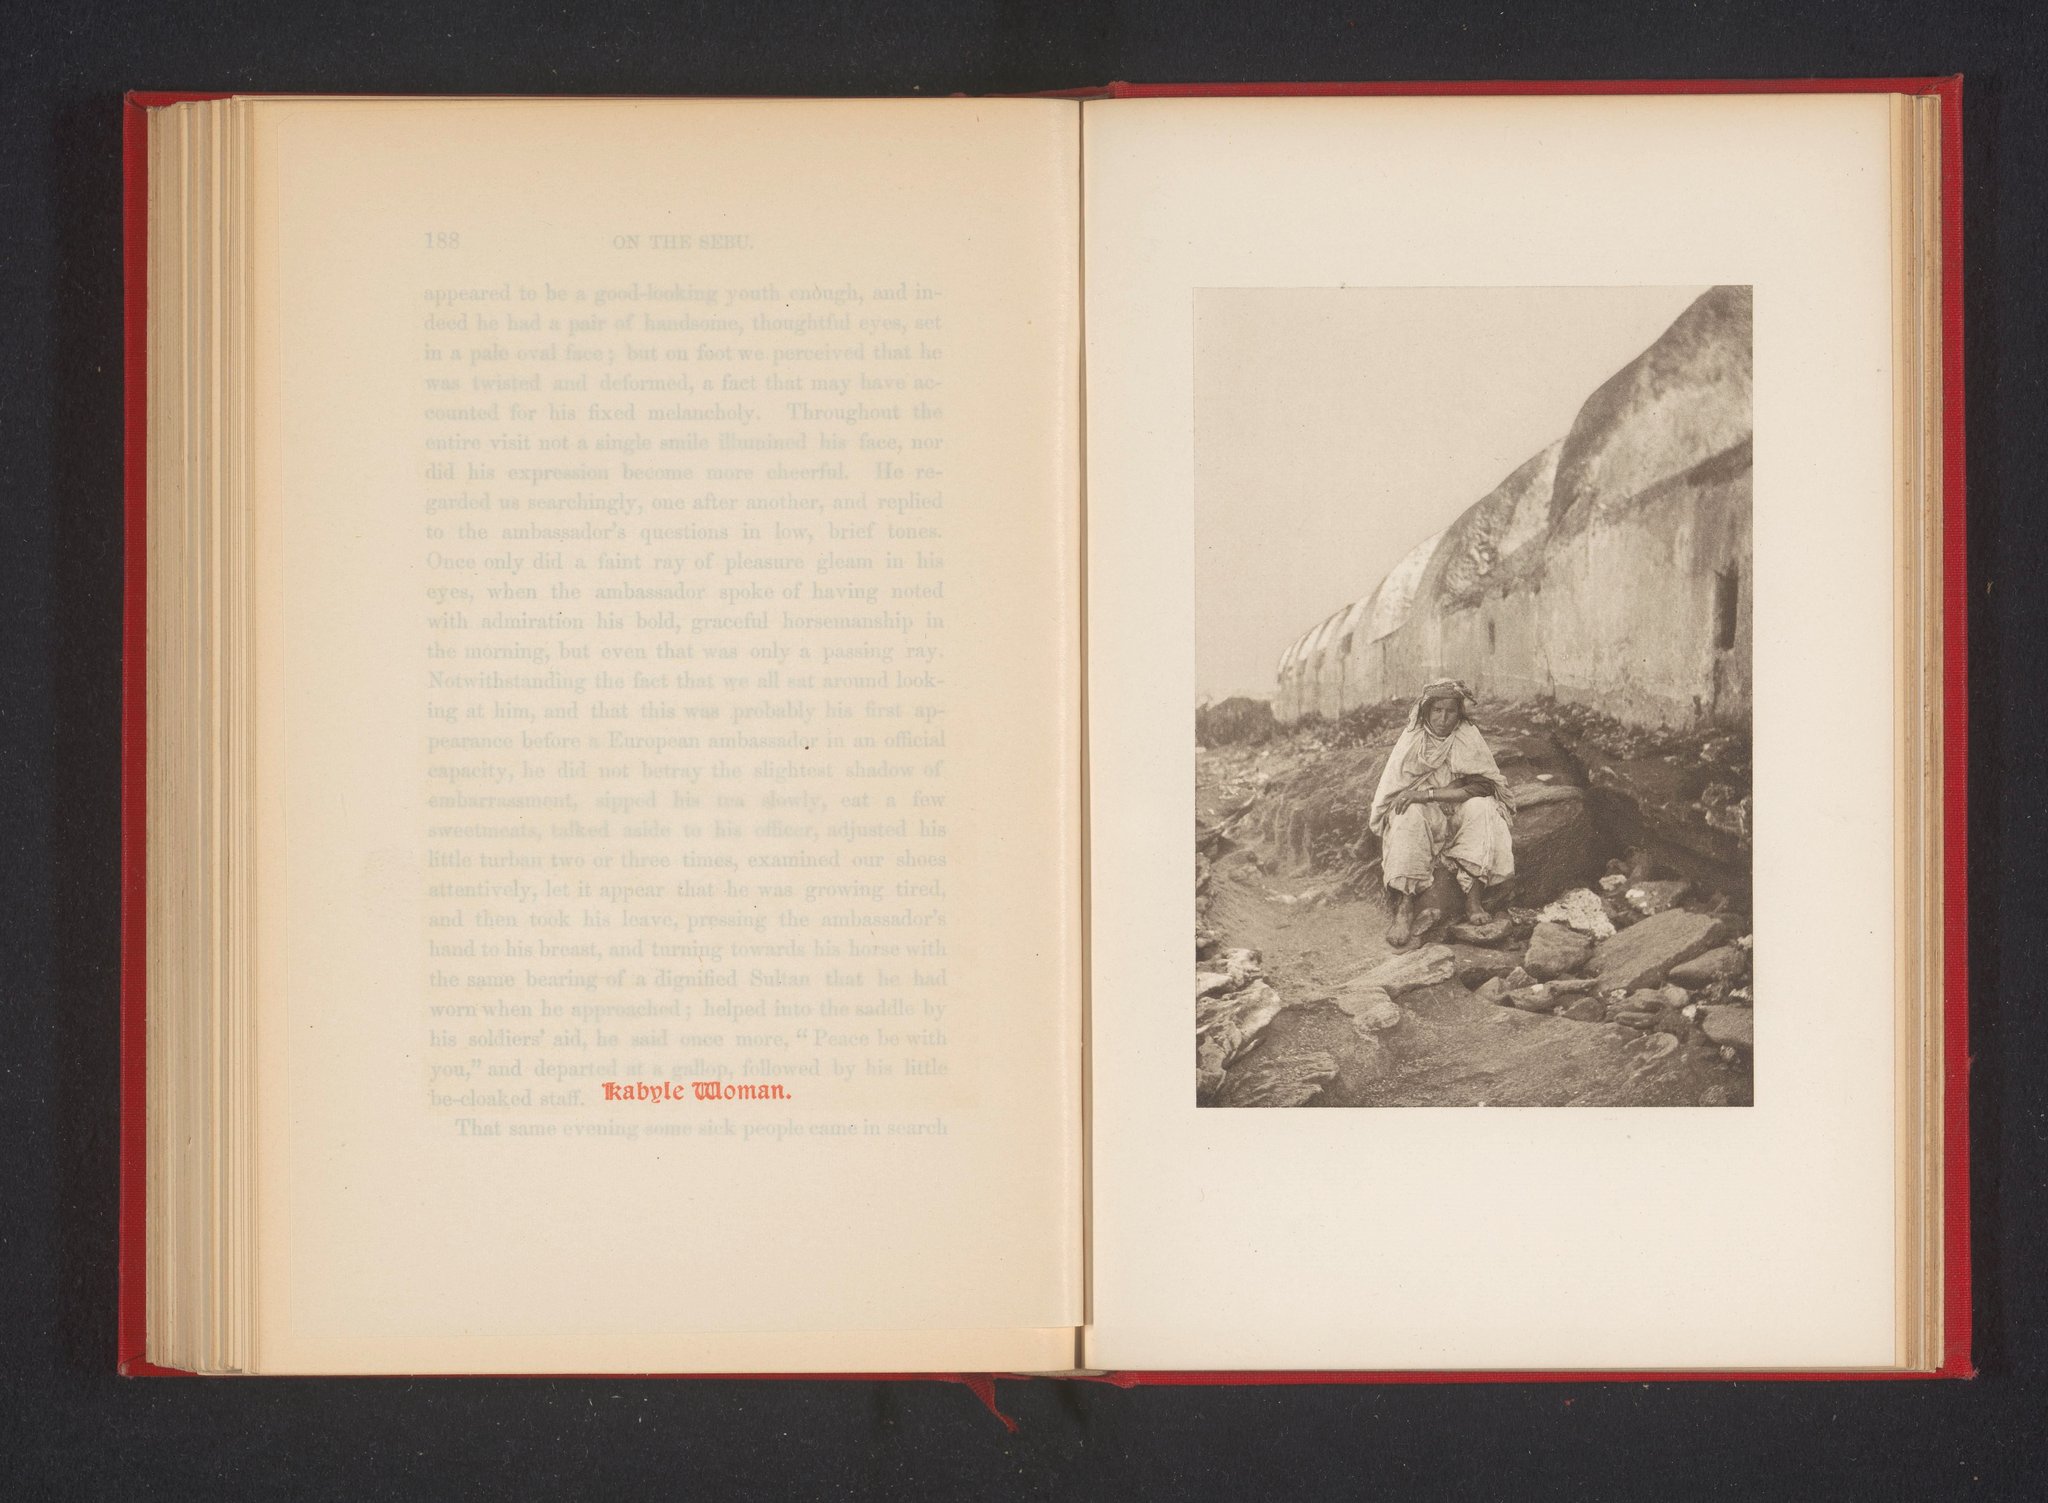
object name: photomechanical print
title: Portret van een onbekende vrouw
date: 1887-1897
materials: paper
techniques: photoaquatint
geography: morocco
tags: adult woman, sitting on the ground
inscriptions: title: ‘Kabyle Woman.’